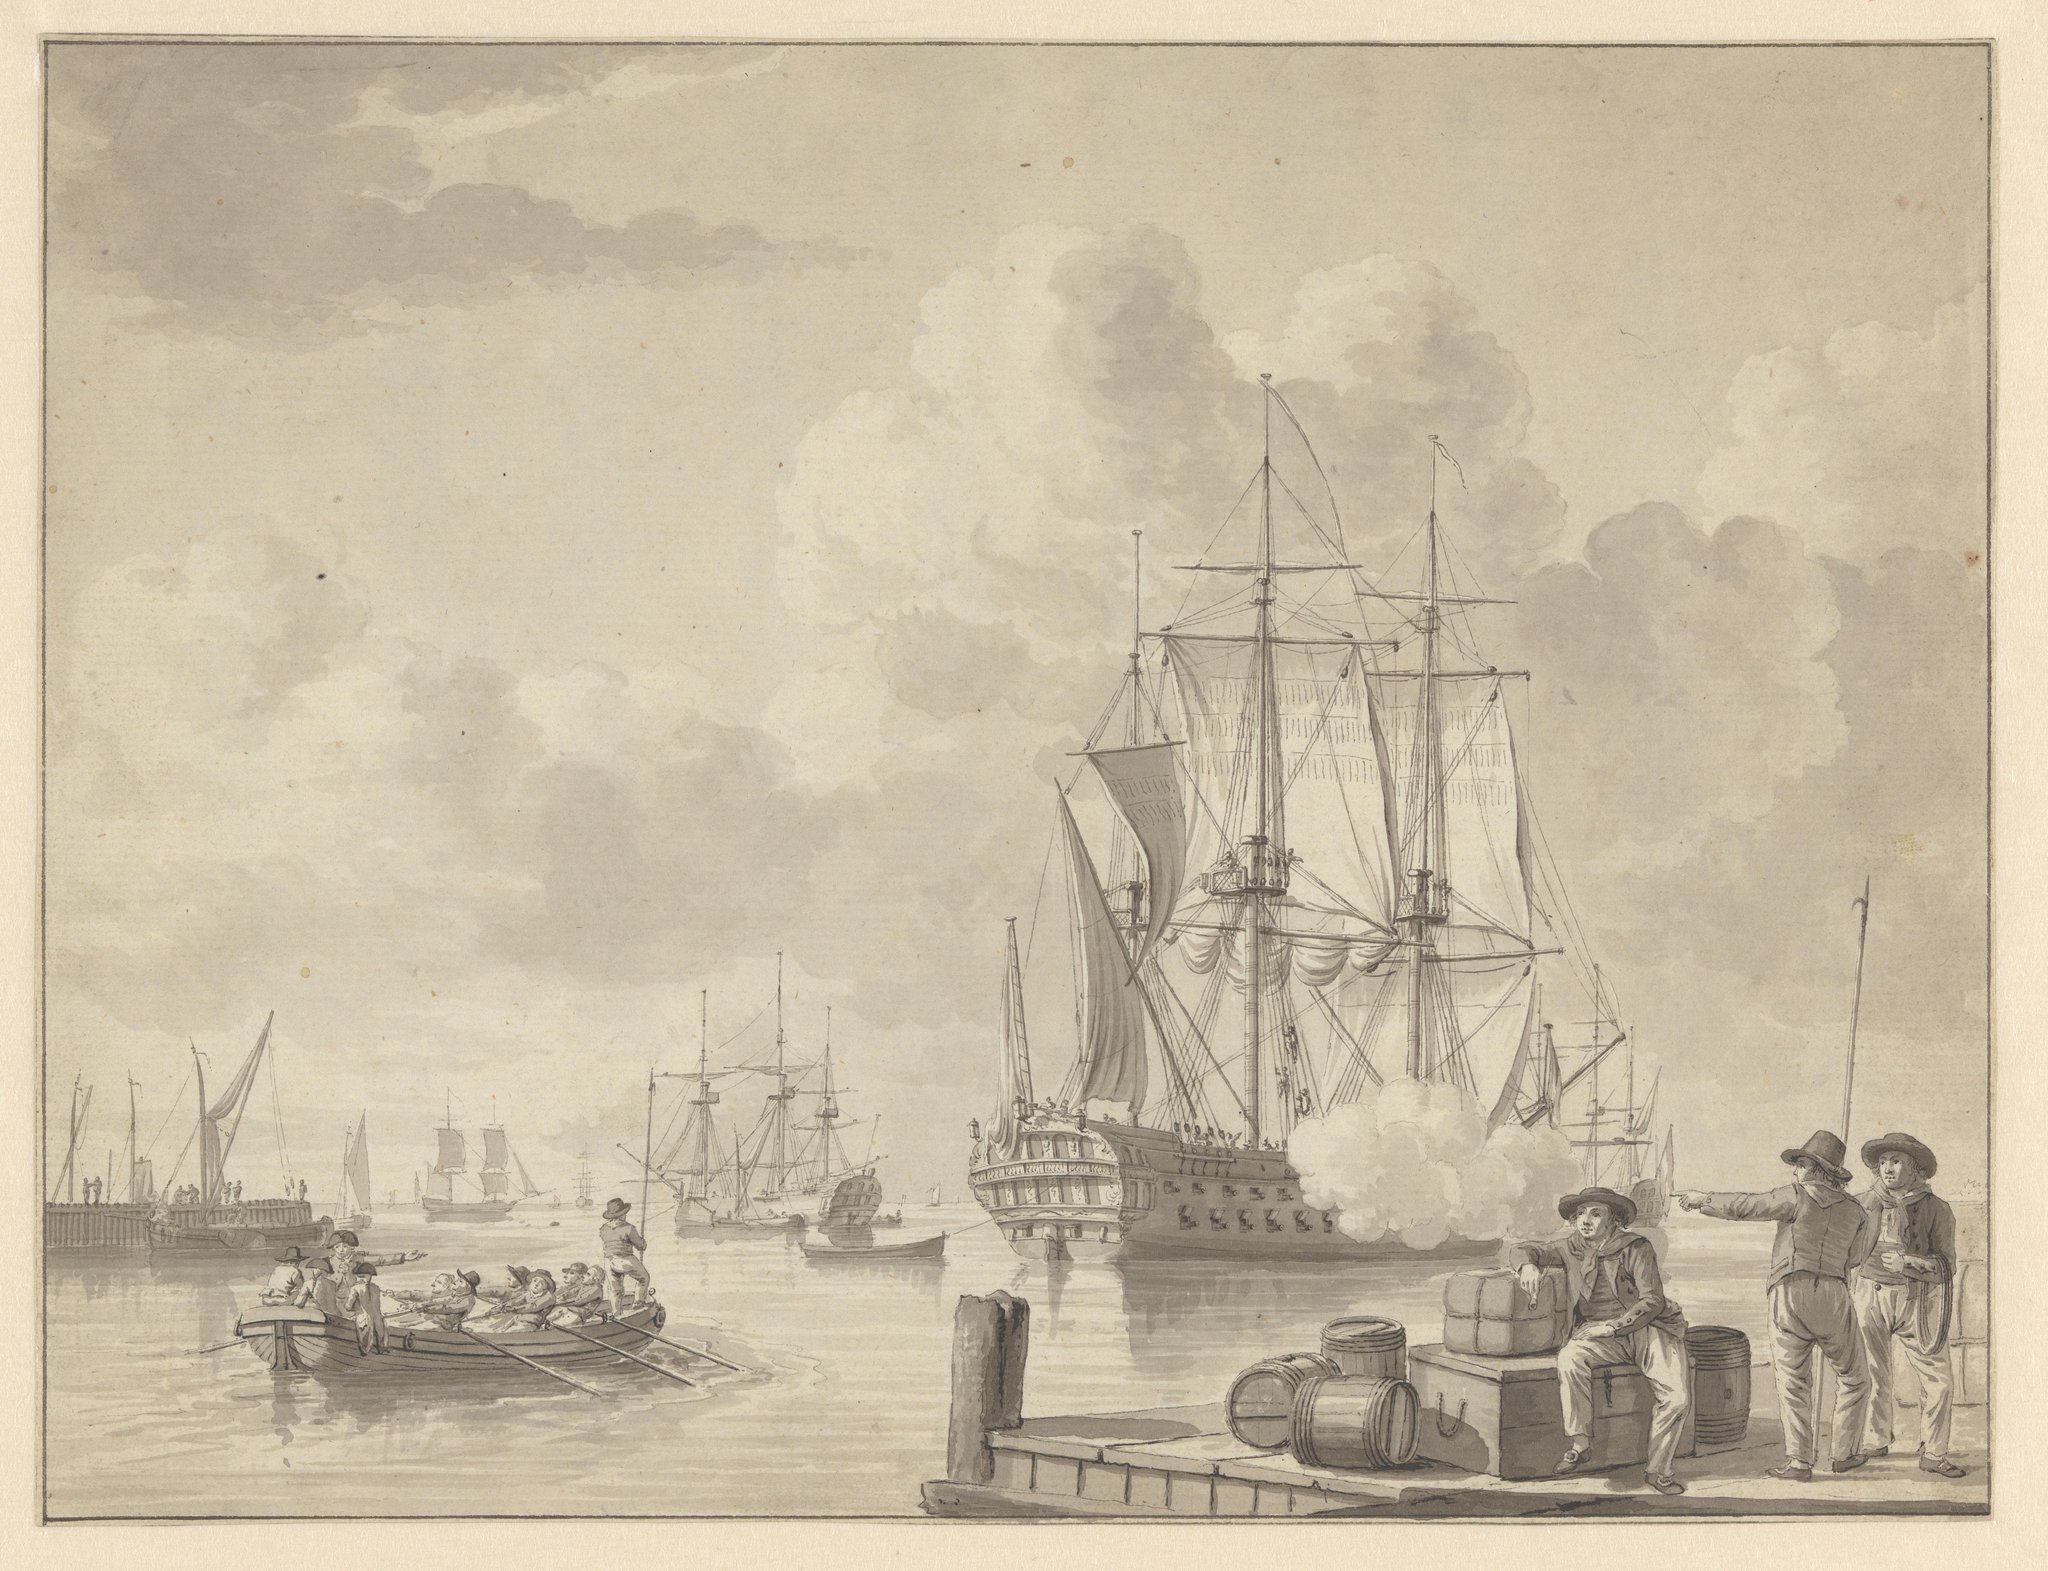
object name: drawing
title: Havengezicht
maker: Anonymous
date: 1700-1800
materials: ink, paper, pencil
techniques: brush, pen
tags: harbour